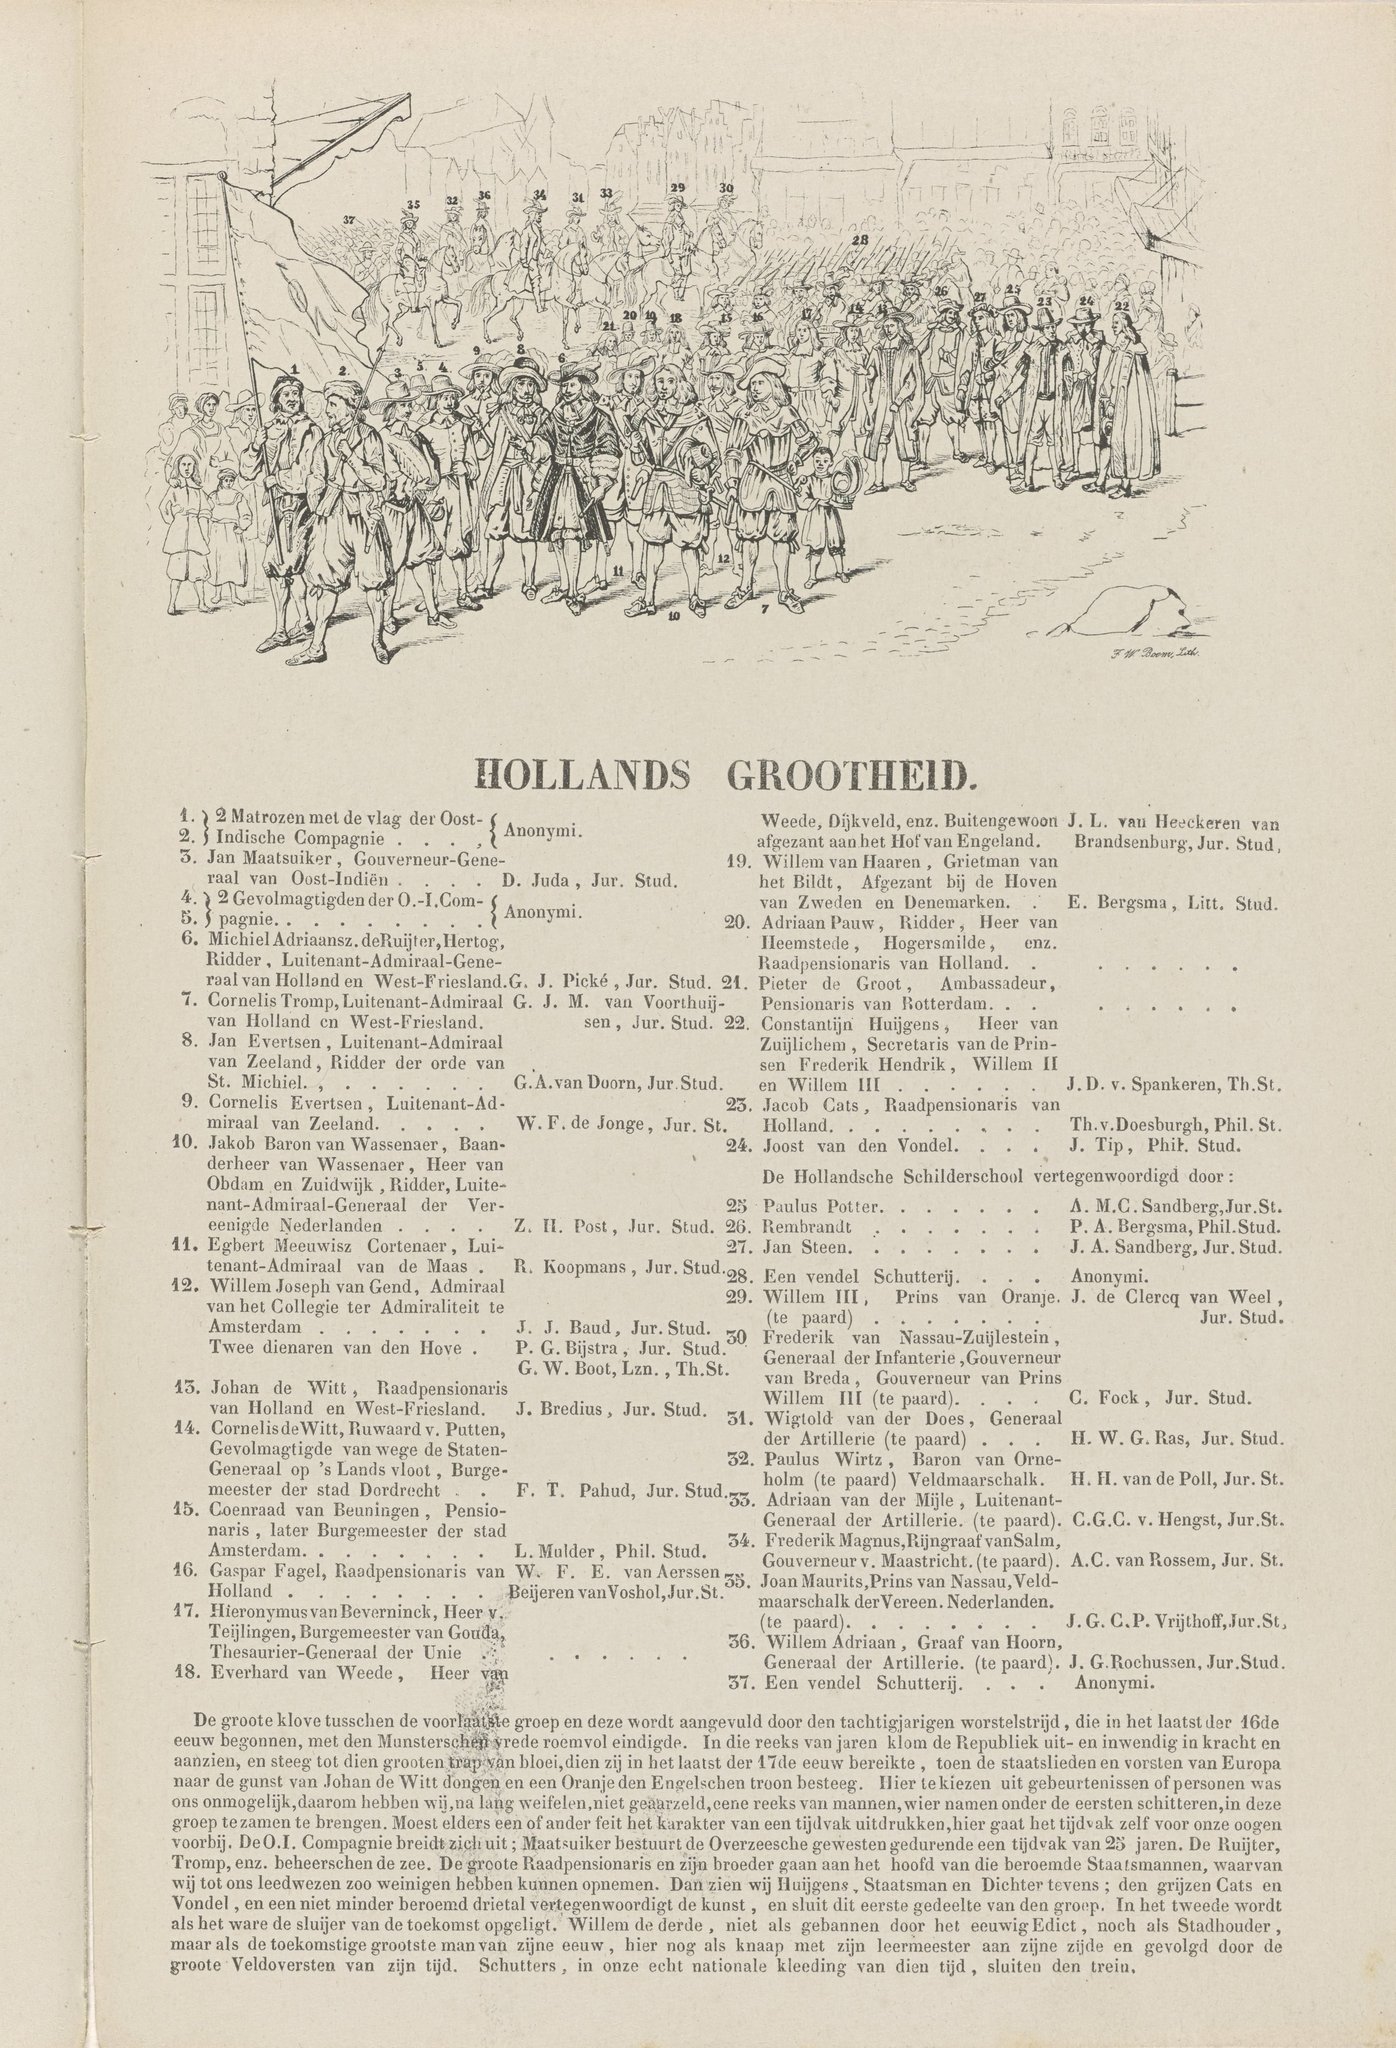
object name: print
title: Hollands Grootheid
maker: f.w. boom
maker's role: print maker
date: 1851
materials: paper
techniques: letterpress printing, lithograph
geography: utrecht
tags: students' pageant, costumes used in pageants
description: Parade van beroemde Hollanders uit het midden van de zeventiende eeuw, ca. 1650-1675. Met legenda 1-37 met de namen van de studenten en daaronder een tekst over de voorgestelde gebeurtenis. Onderdeel van het boekje met acht verkleinde voorstellingen van de acht prenten in de serie van de maskerade van de Utrechtse studenten, 25 juni 1851. De maskerade verbeeldt in taferelen acht episodes uit de vaderlandse geschiedenis.